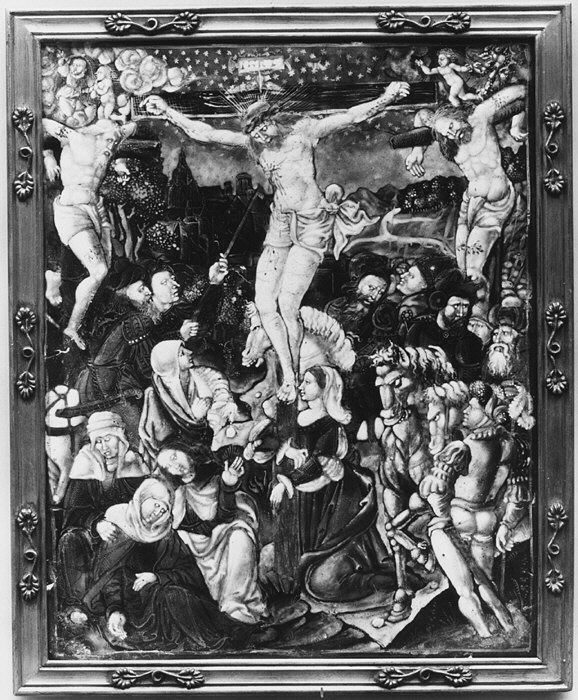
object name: plaque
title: The Crucifixion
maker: alfred andré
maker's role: maker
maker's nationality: french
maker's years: 1839-1919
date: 1801-1933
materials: copper, enamel, gilt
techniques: painting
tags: sadness,horses,christ,mary magdalene,virgin mary,crucifixion